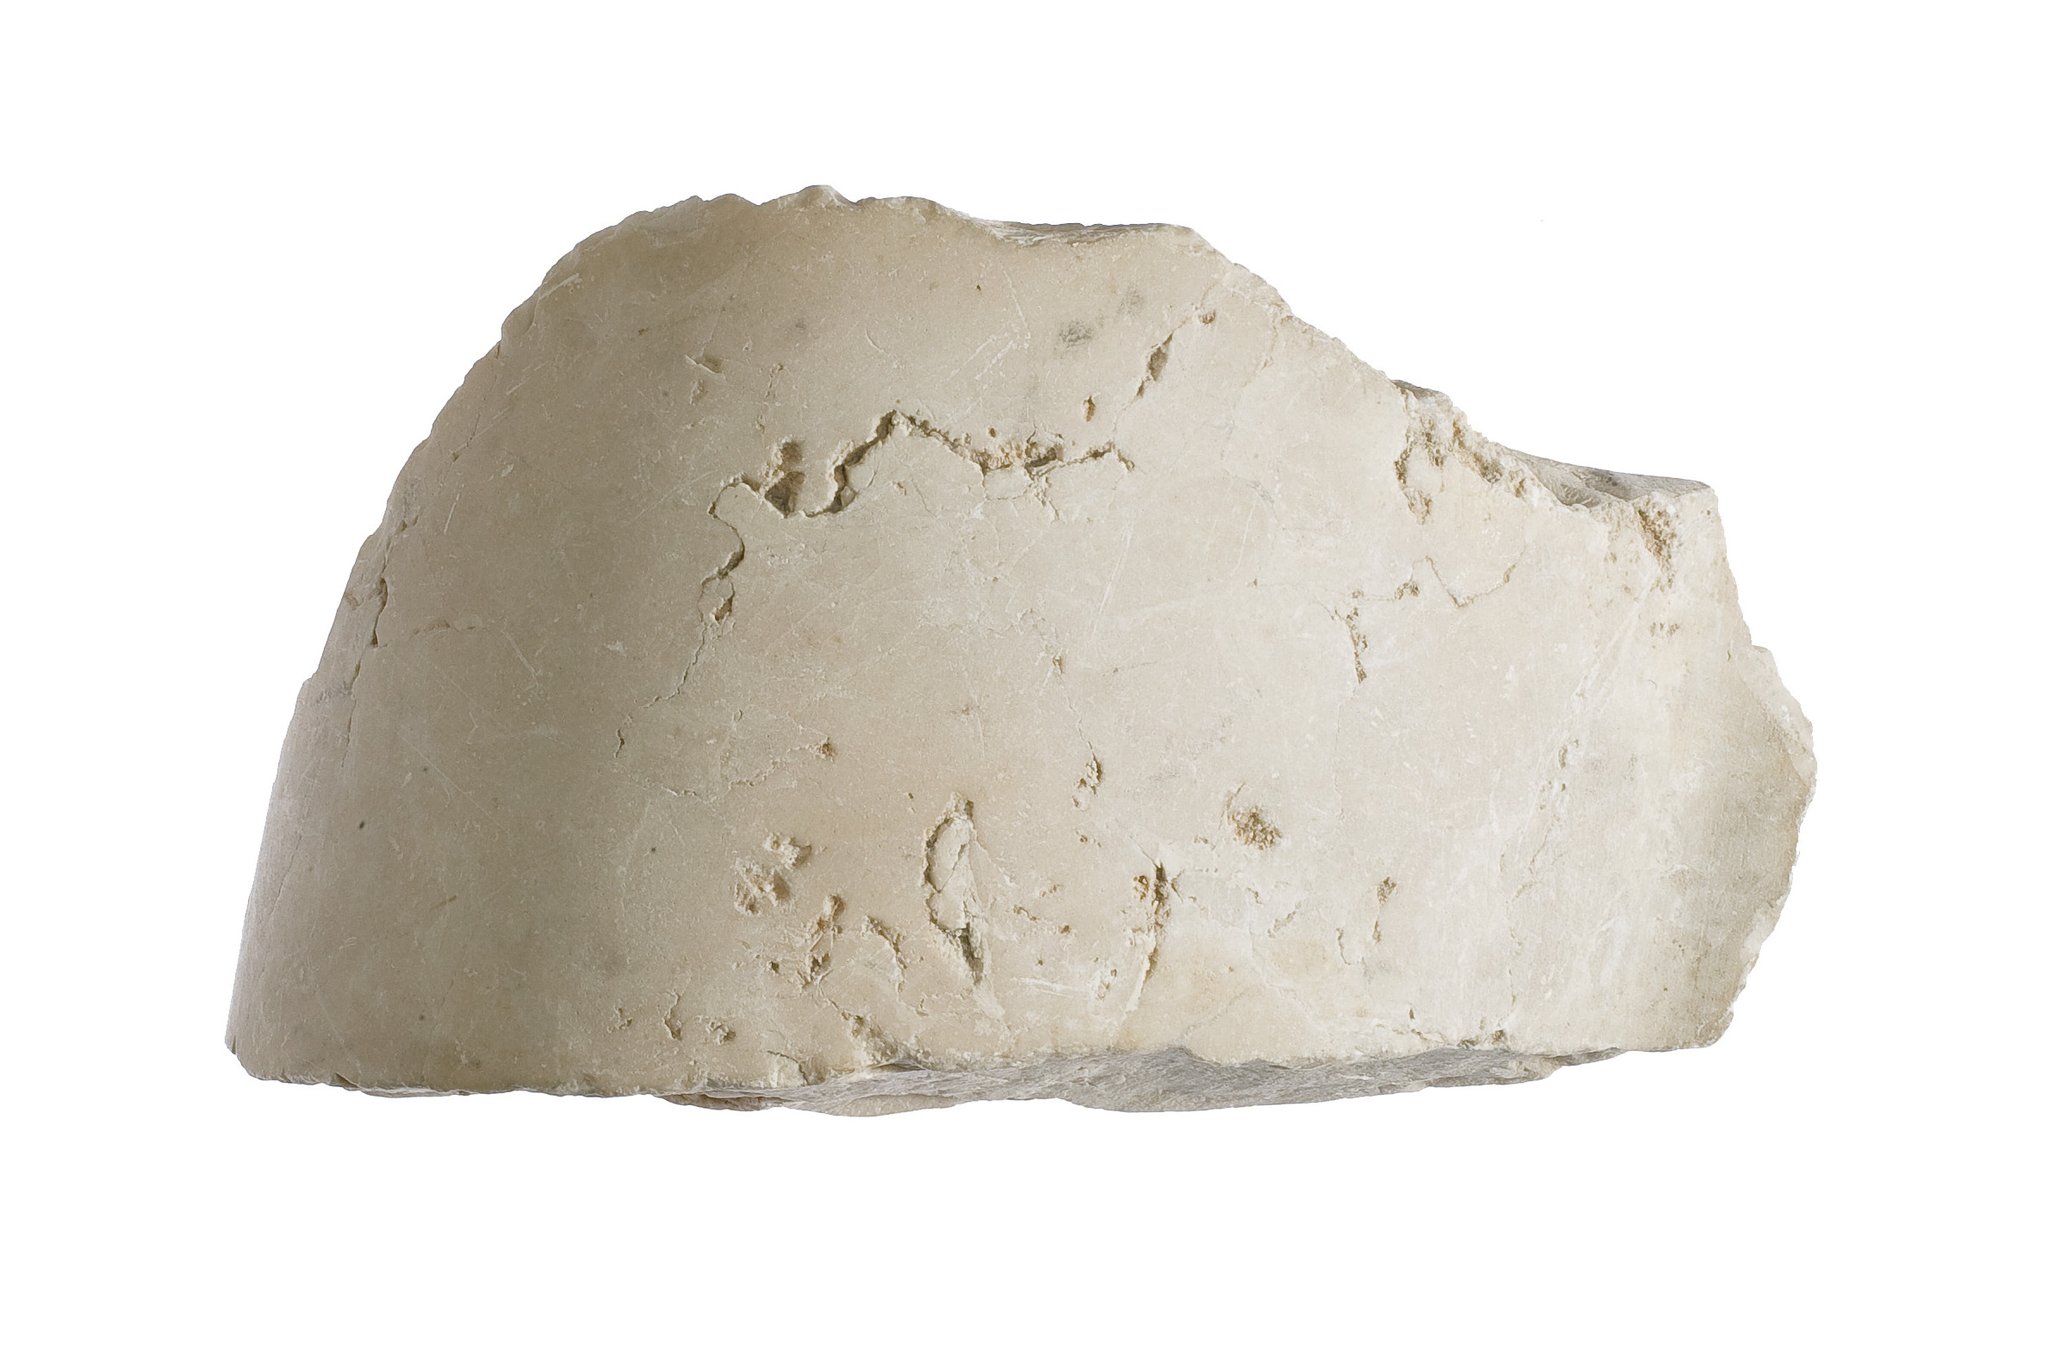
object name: arm fragment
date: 1353-1336 BCE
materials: limestone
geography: egypt